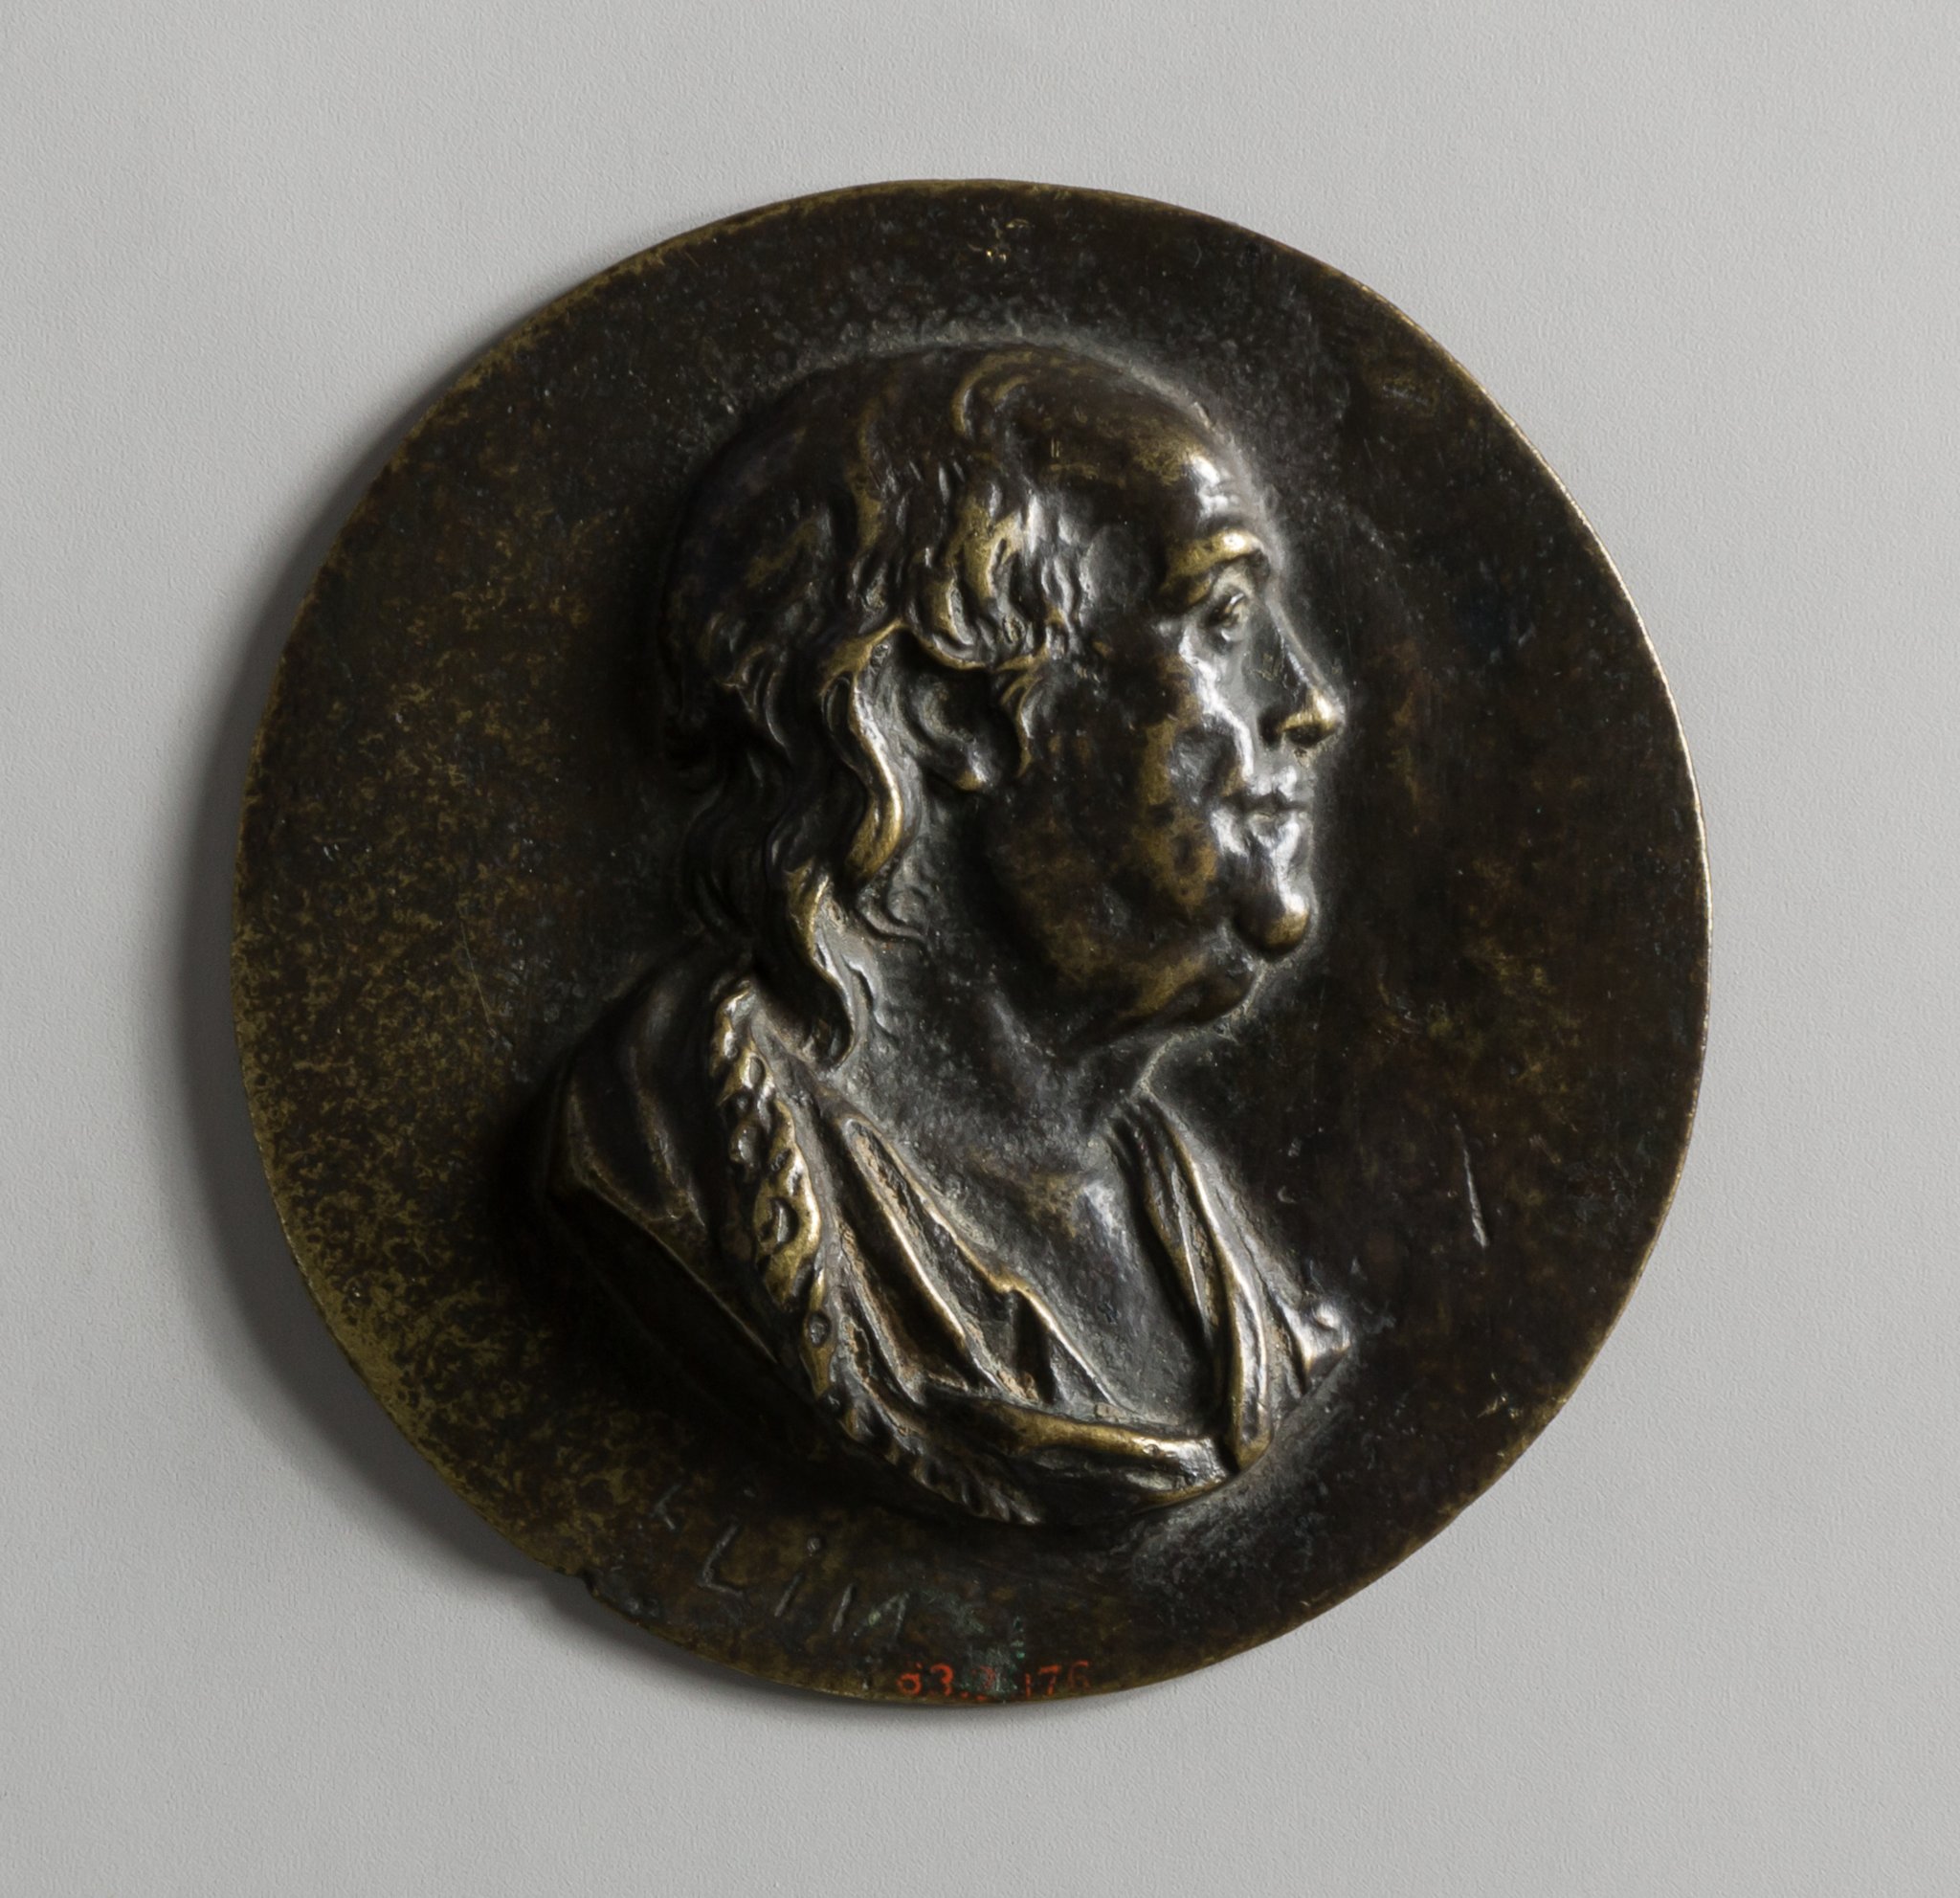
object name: medallion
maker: augustin dupré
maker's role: artist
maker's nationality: french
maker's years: 1748-1833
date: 1776-1883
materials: bronze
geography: france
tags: benjamin franklin,men,profiles